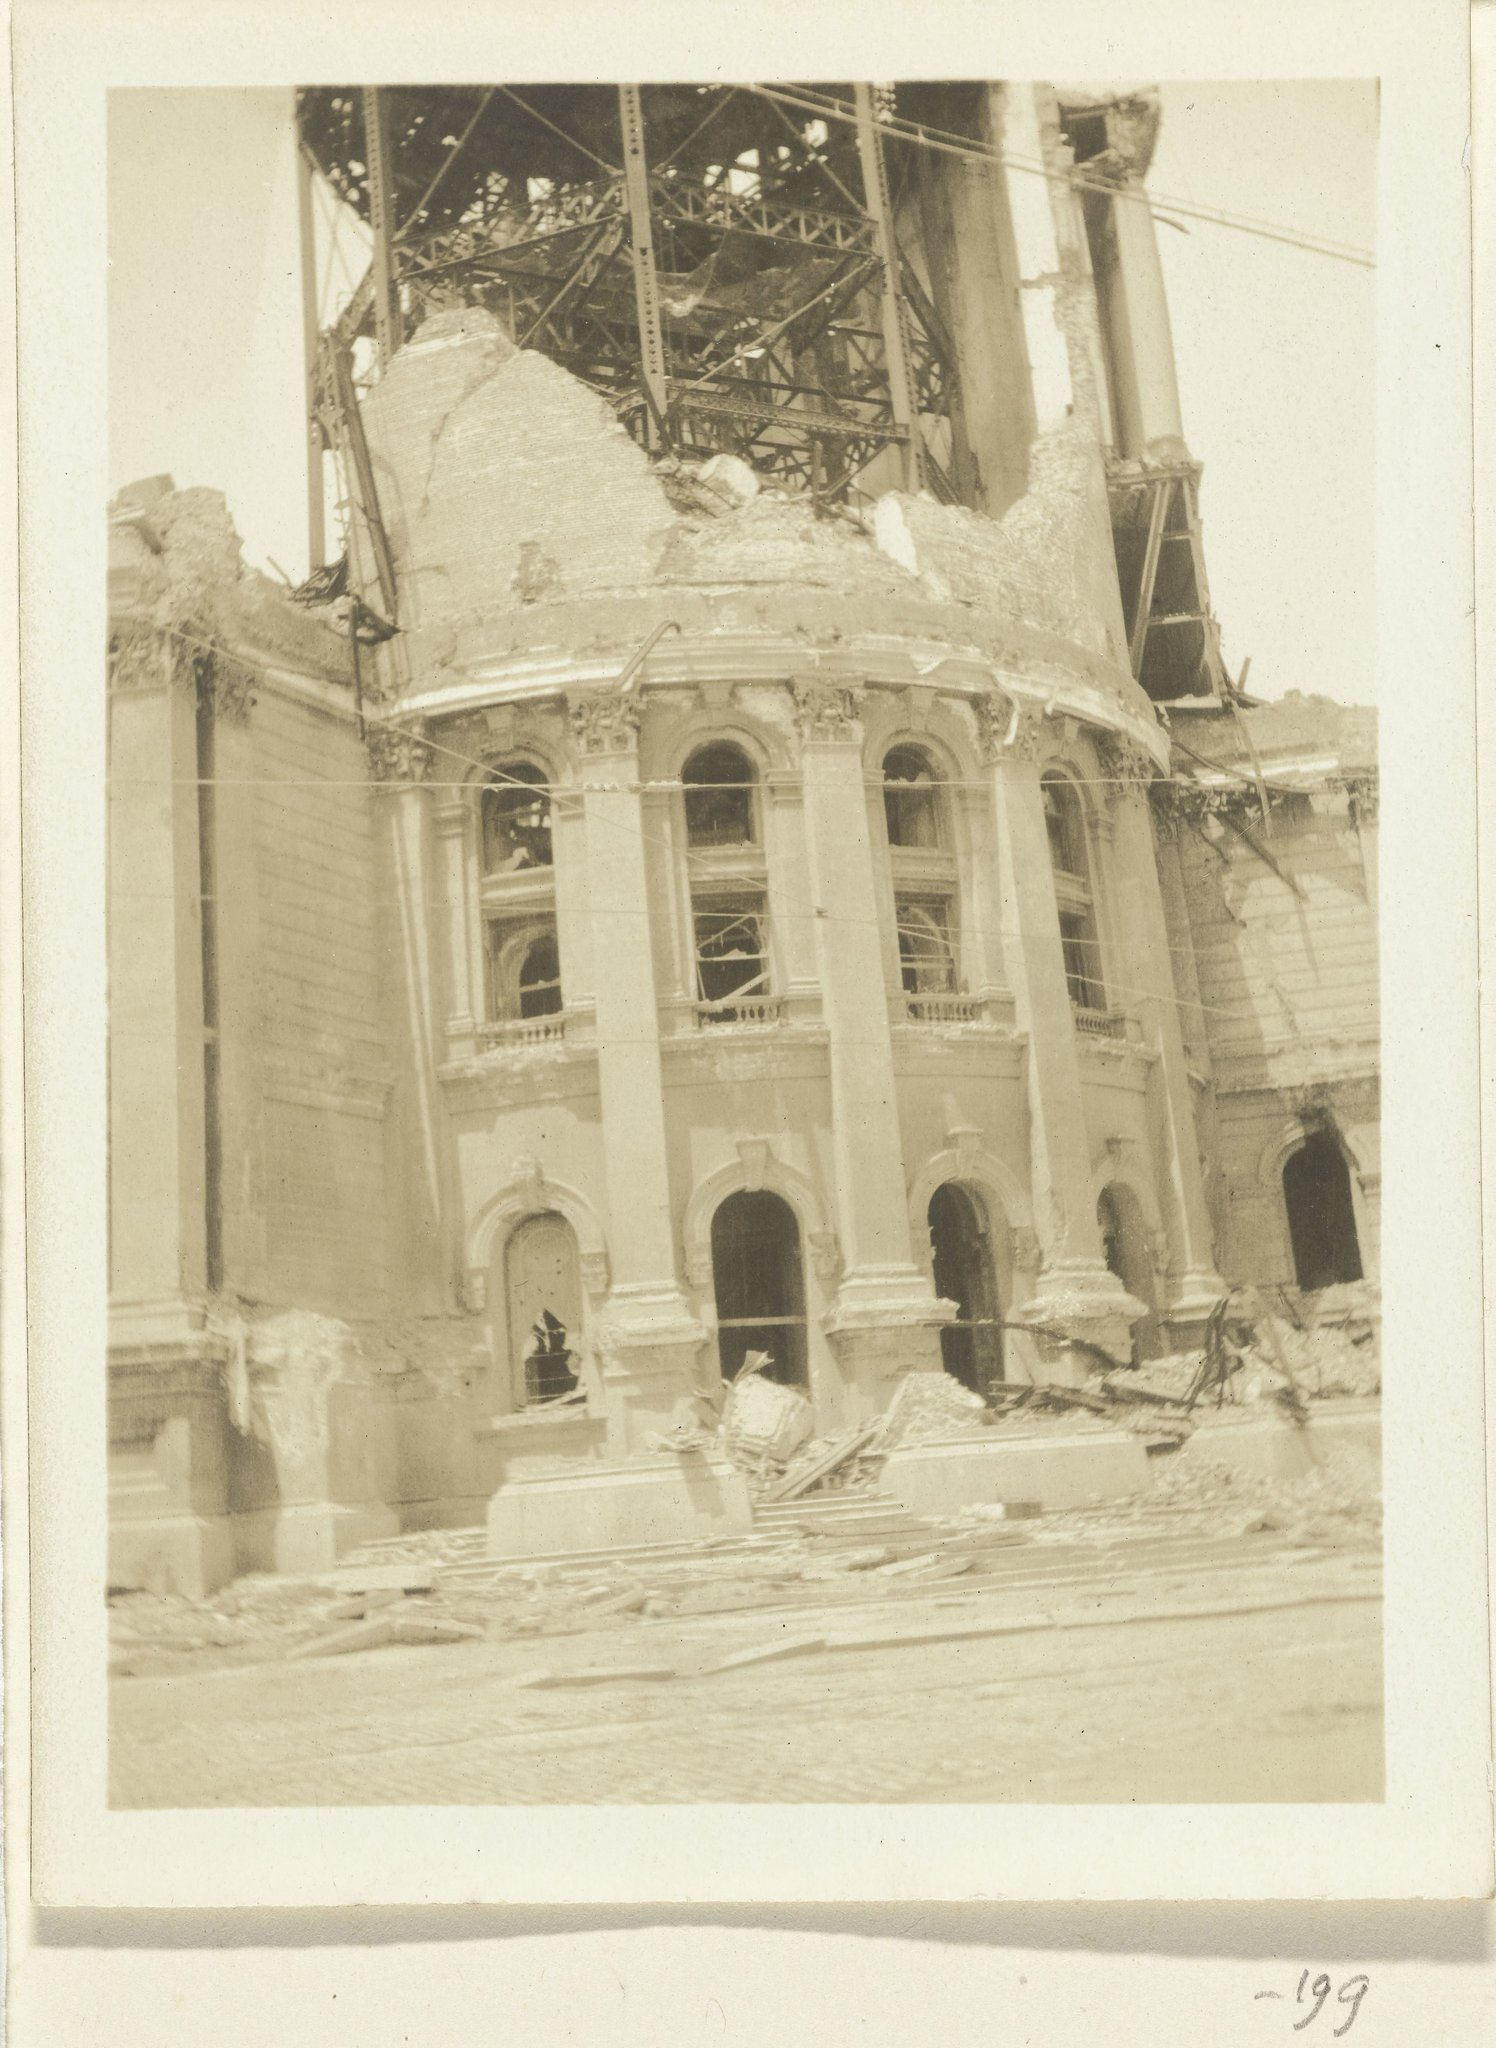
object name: photograph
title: De verwoeste City Hall in San Francisco na de aardbeving van 1906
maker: geldolph adriaan kessler (dolph)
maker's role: fotograaf, industrieel, voetballer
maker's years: 1884-1945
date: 1905-1908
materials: cardboard, photographic support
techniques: gelatin silver print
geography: san francisco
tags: san francisco, aardbeving san francisco 1906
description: De na de aardbeving van 1906 verwoeste City Hall in San Francisco. Onderdeel van het fotoalbum van Dolph Kessler met opnamen die hij maakte tijdens zijn verblijf in Engeland en op een wereldreis die hij als secretaris van Henri Deterding (directeur Koninklijke Olie) ondernam naar Nederlands-Indië, Japan, China en de Verenigde Staten, tussen 1906 en 1908.